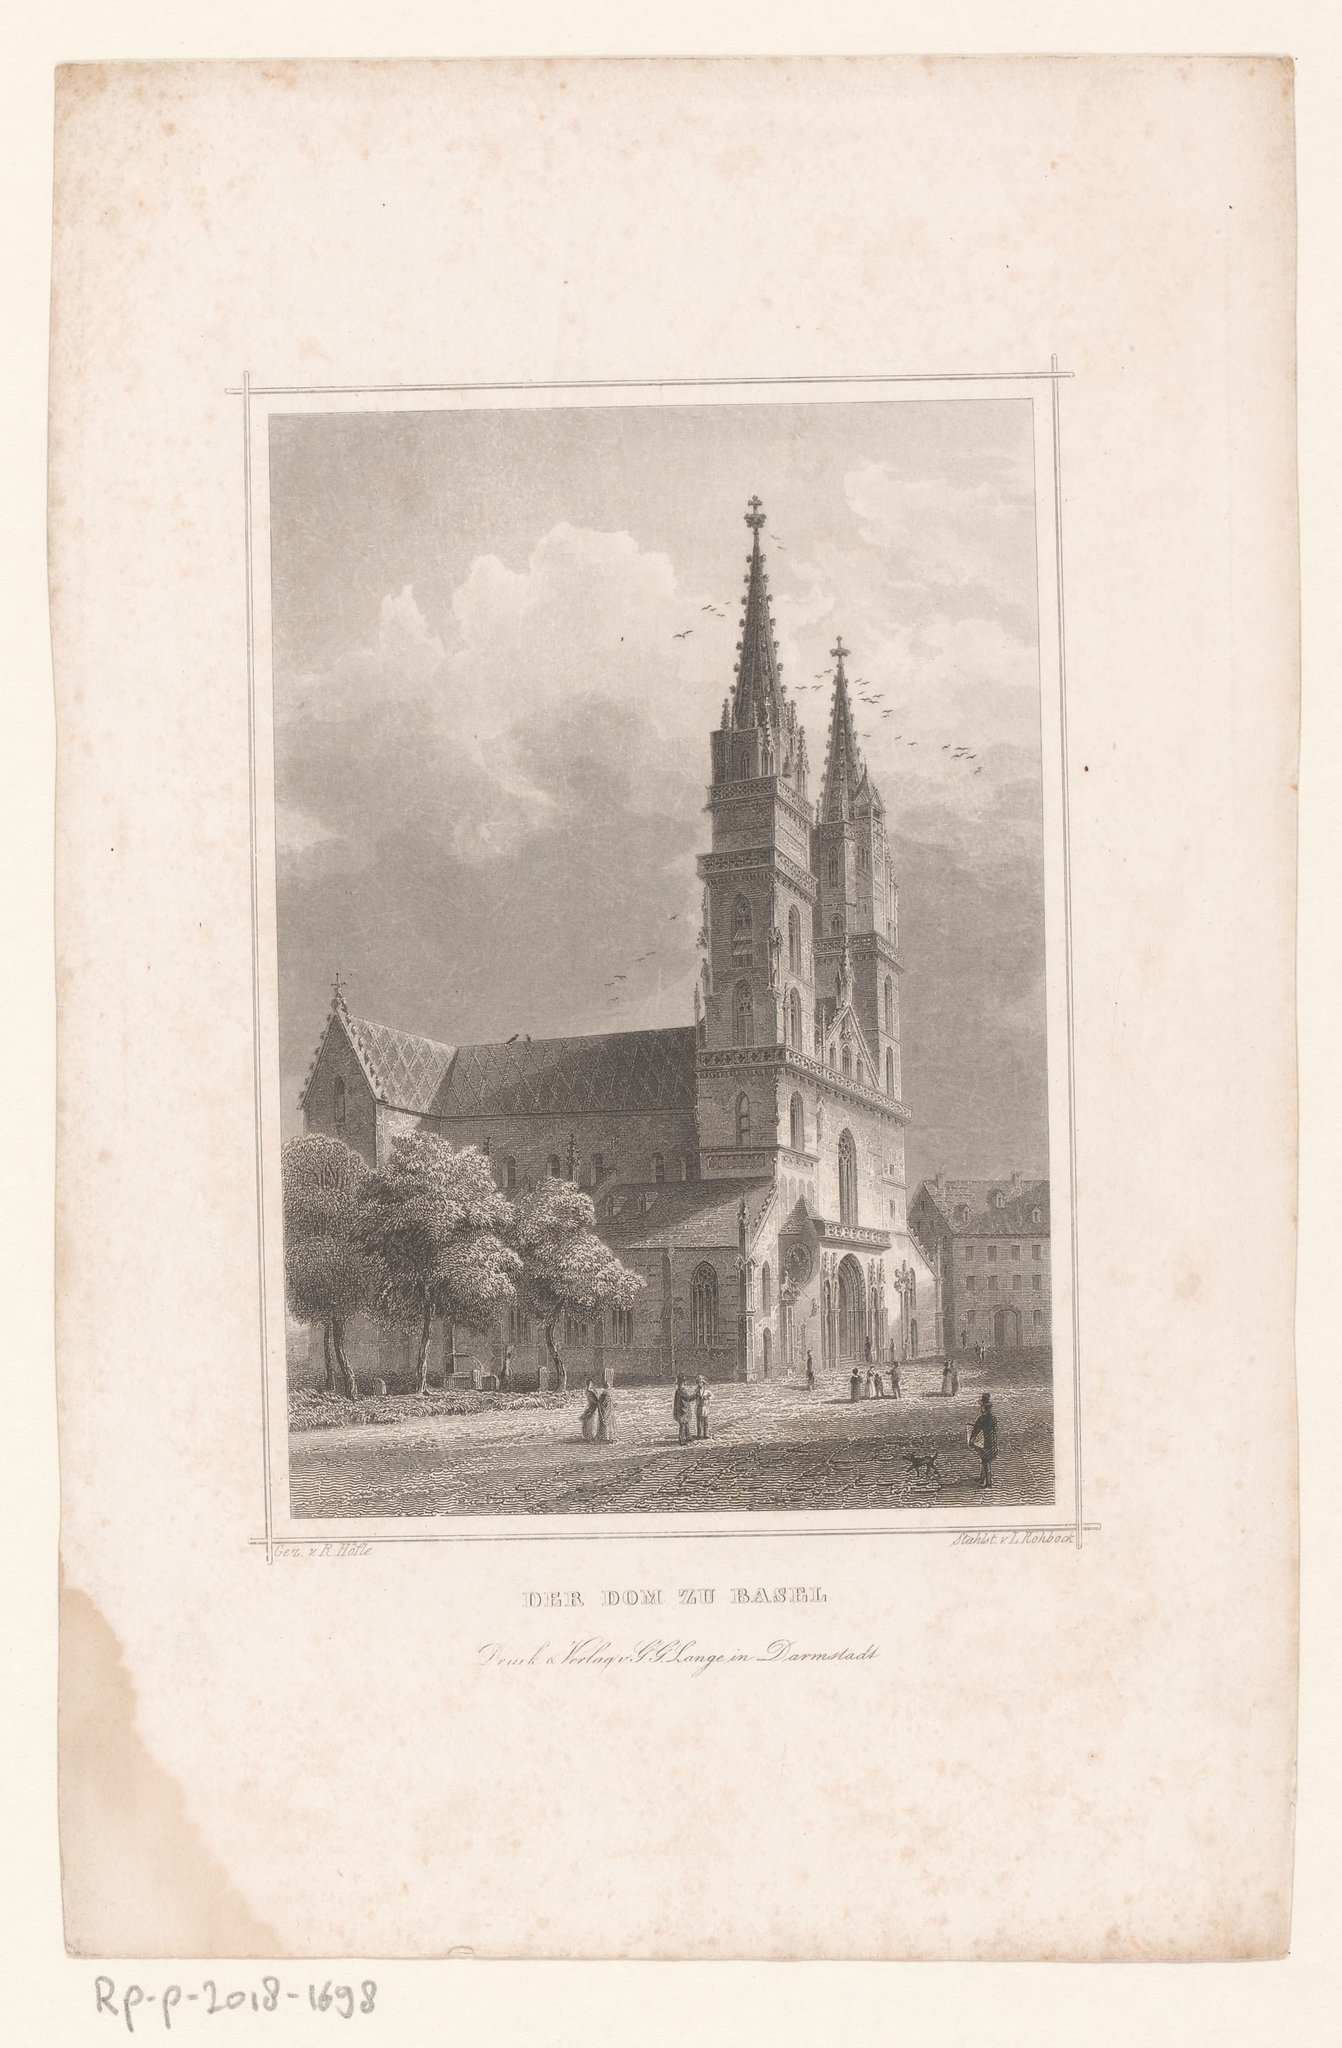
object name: print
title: Gezicht op het munster van Bazel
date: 1831-1843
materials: paper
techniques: engraving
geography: darmstadt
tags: church (exterior)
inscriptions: collector's mark: Lugt 2228